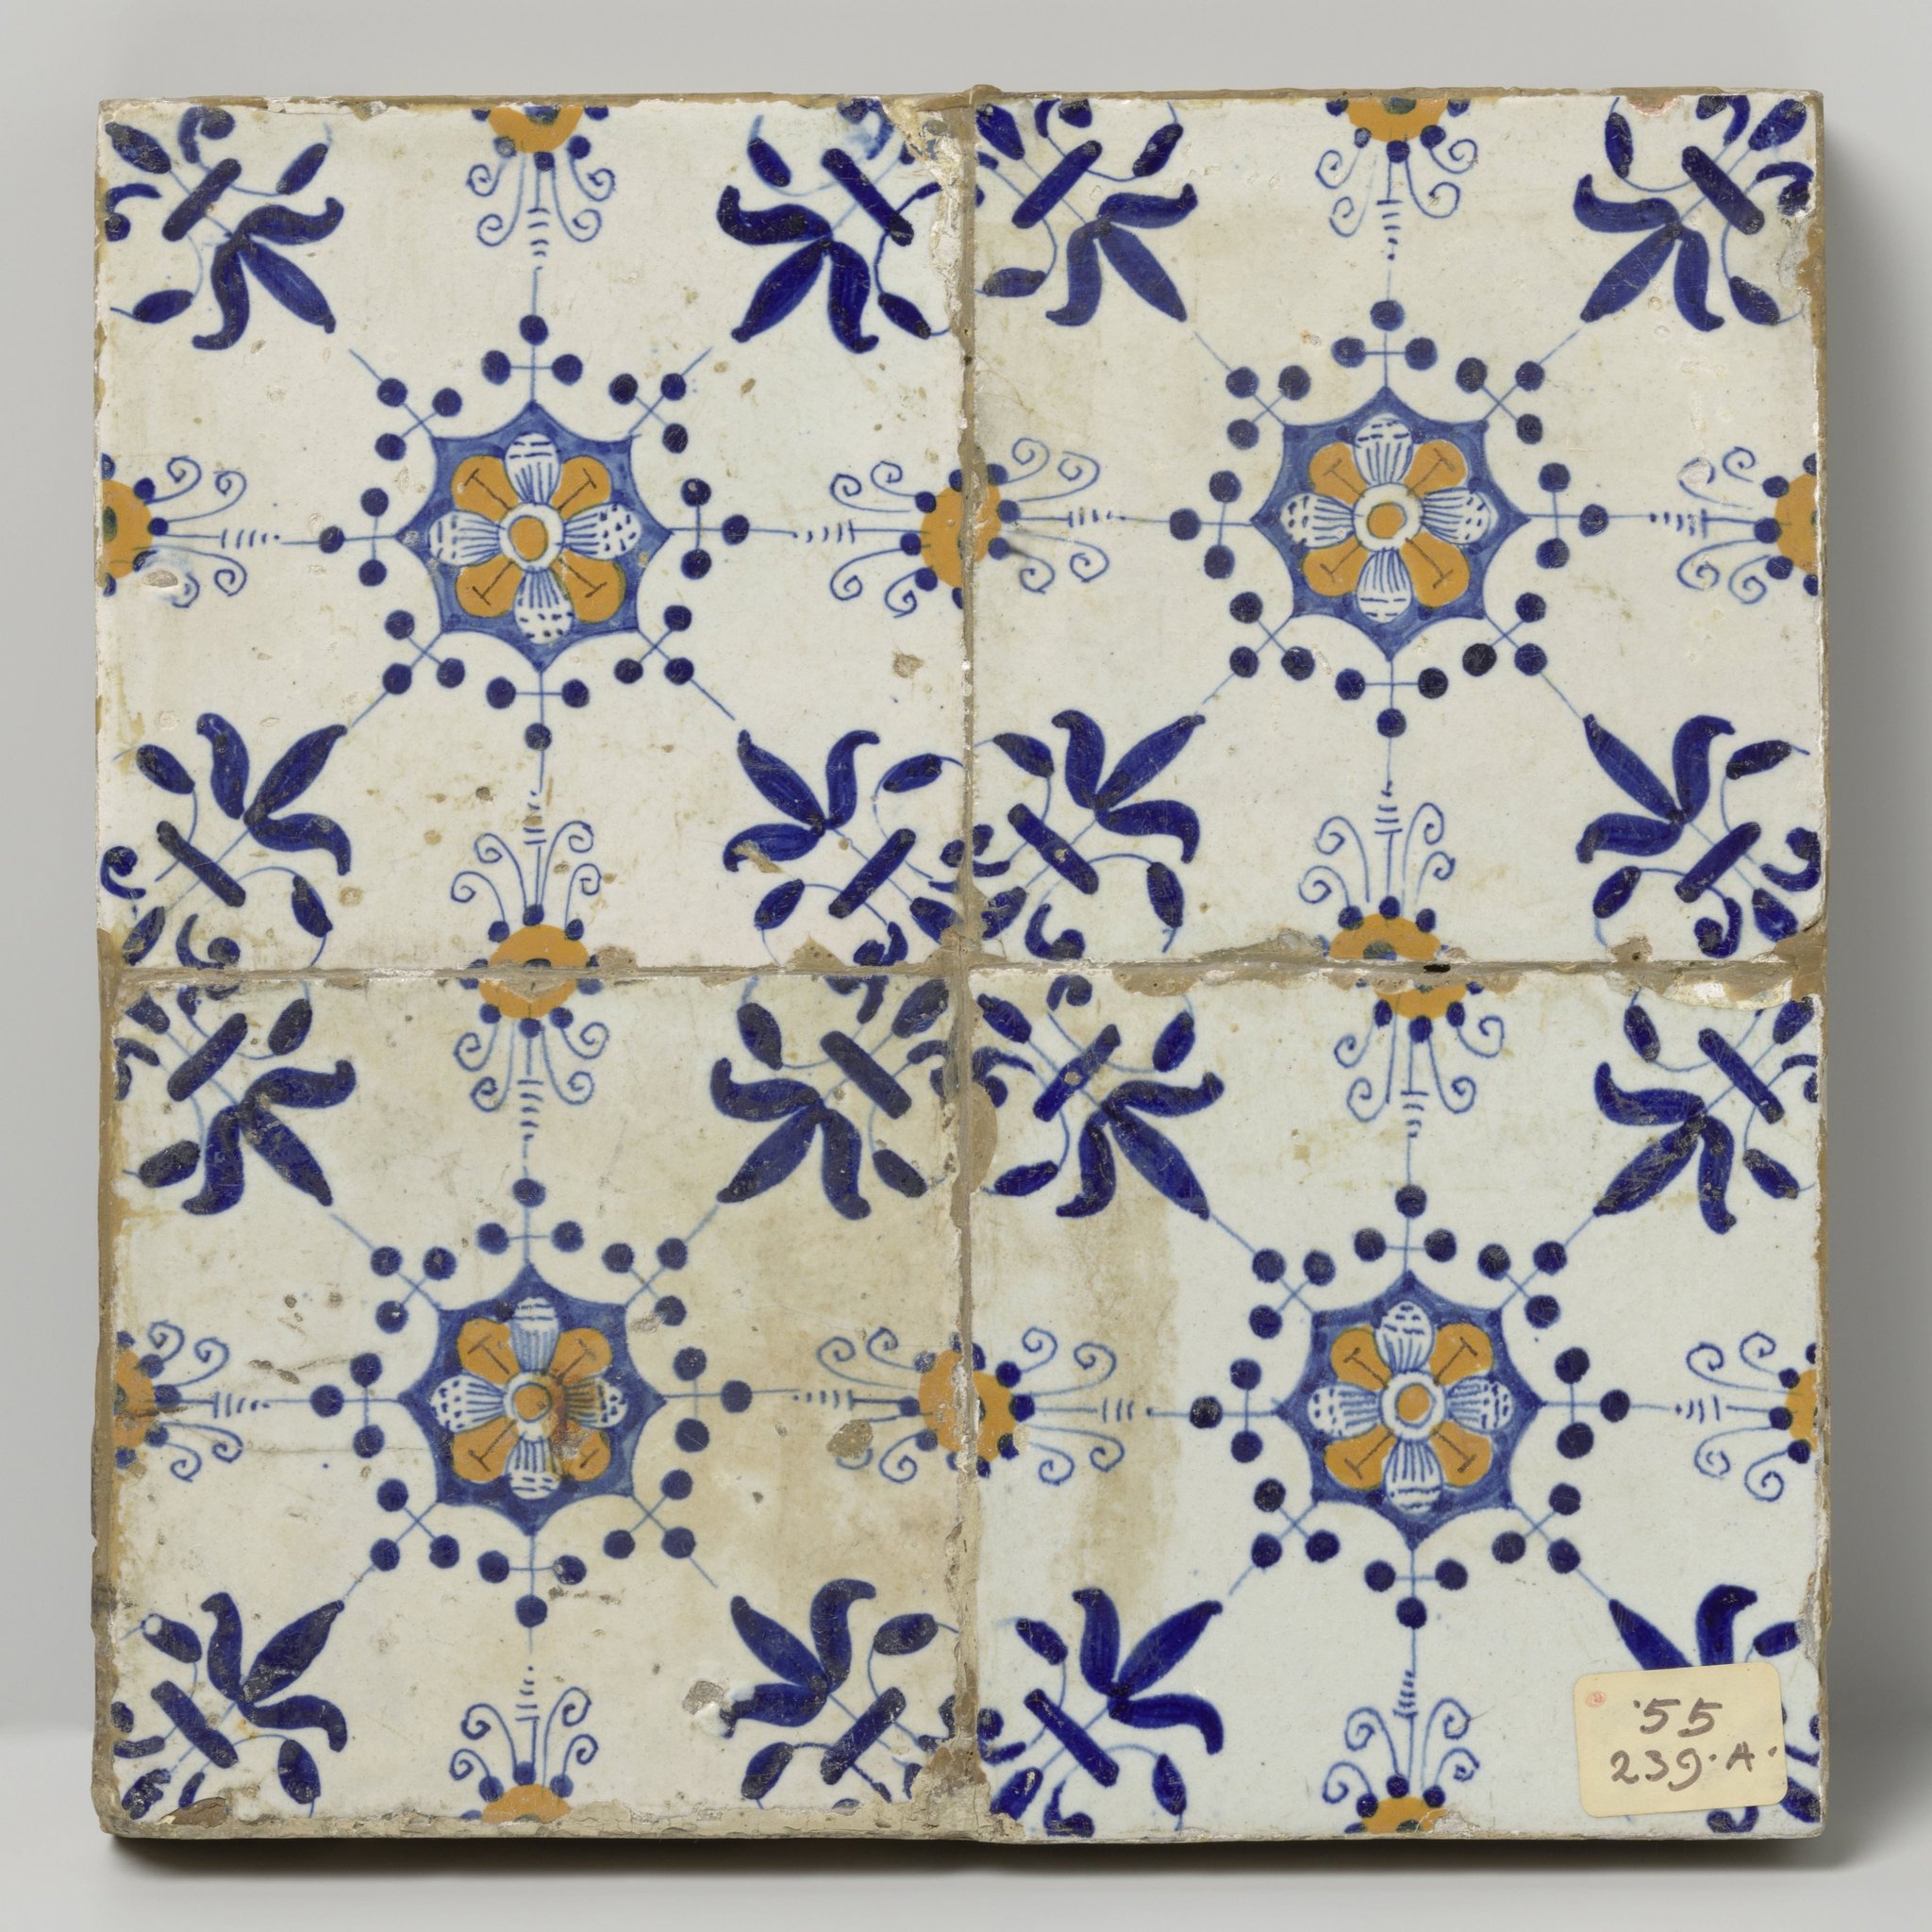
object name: ornamenttegel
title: Veld van vier tegels met rozetten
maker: Anonymous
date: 1640-1660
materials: earthenware, glaze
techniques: maiolica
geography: haarlem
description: Veld van vier tegels (2 x 2) elk met een blauw en geel geschilderde rozet binnen een achtkant versierd met driestippen. Langs de randen, een halve rozet en in de hoeken, een lelie.